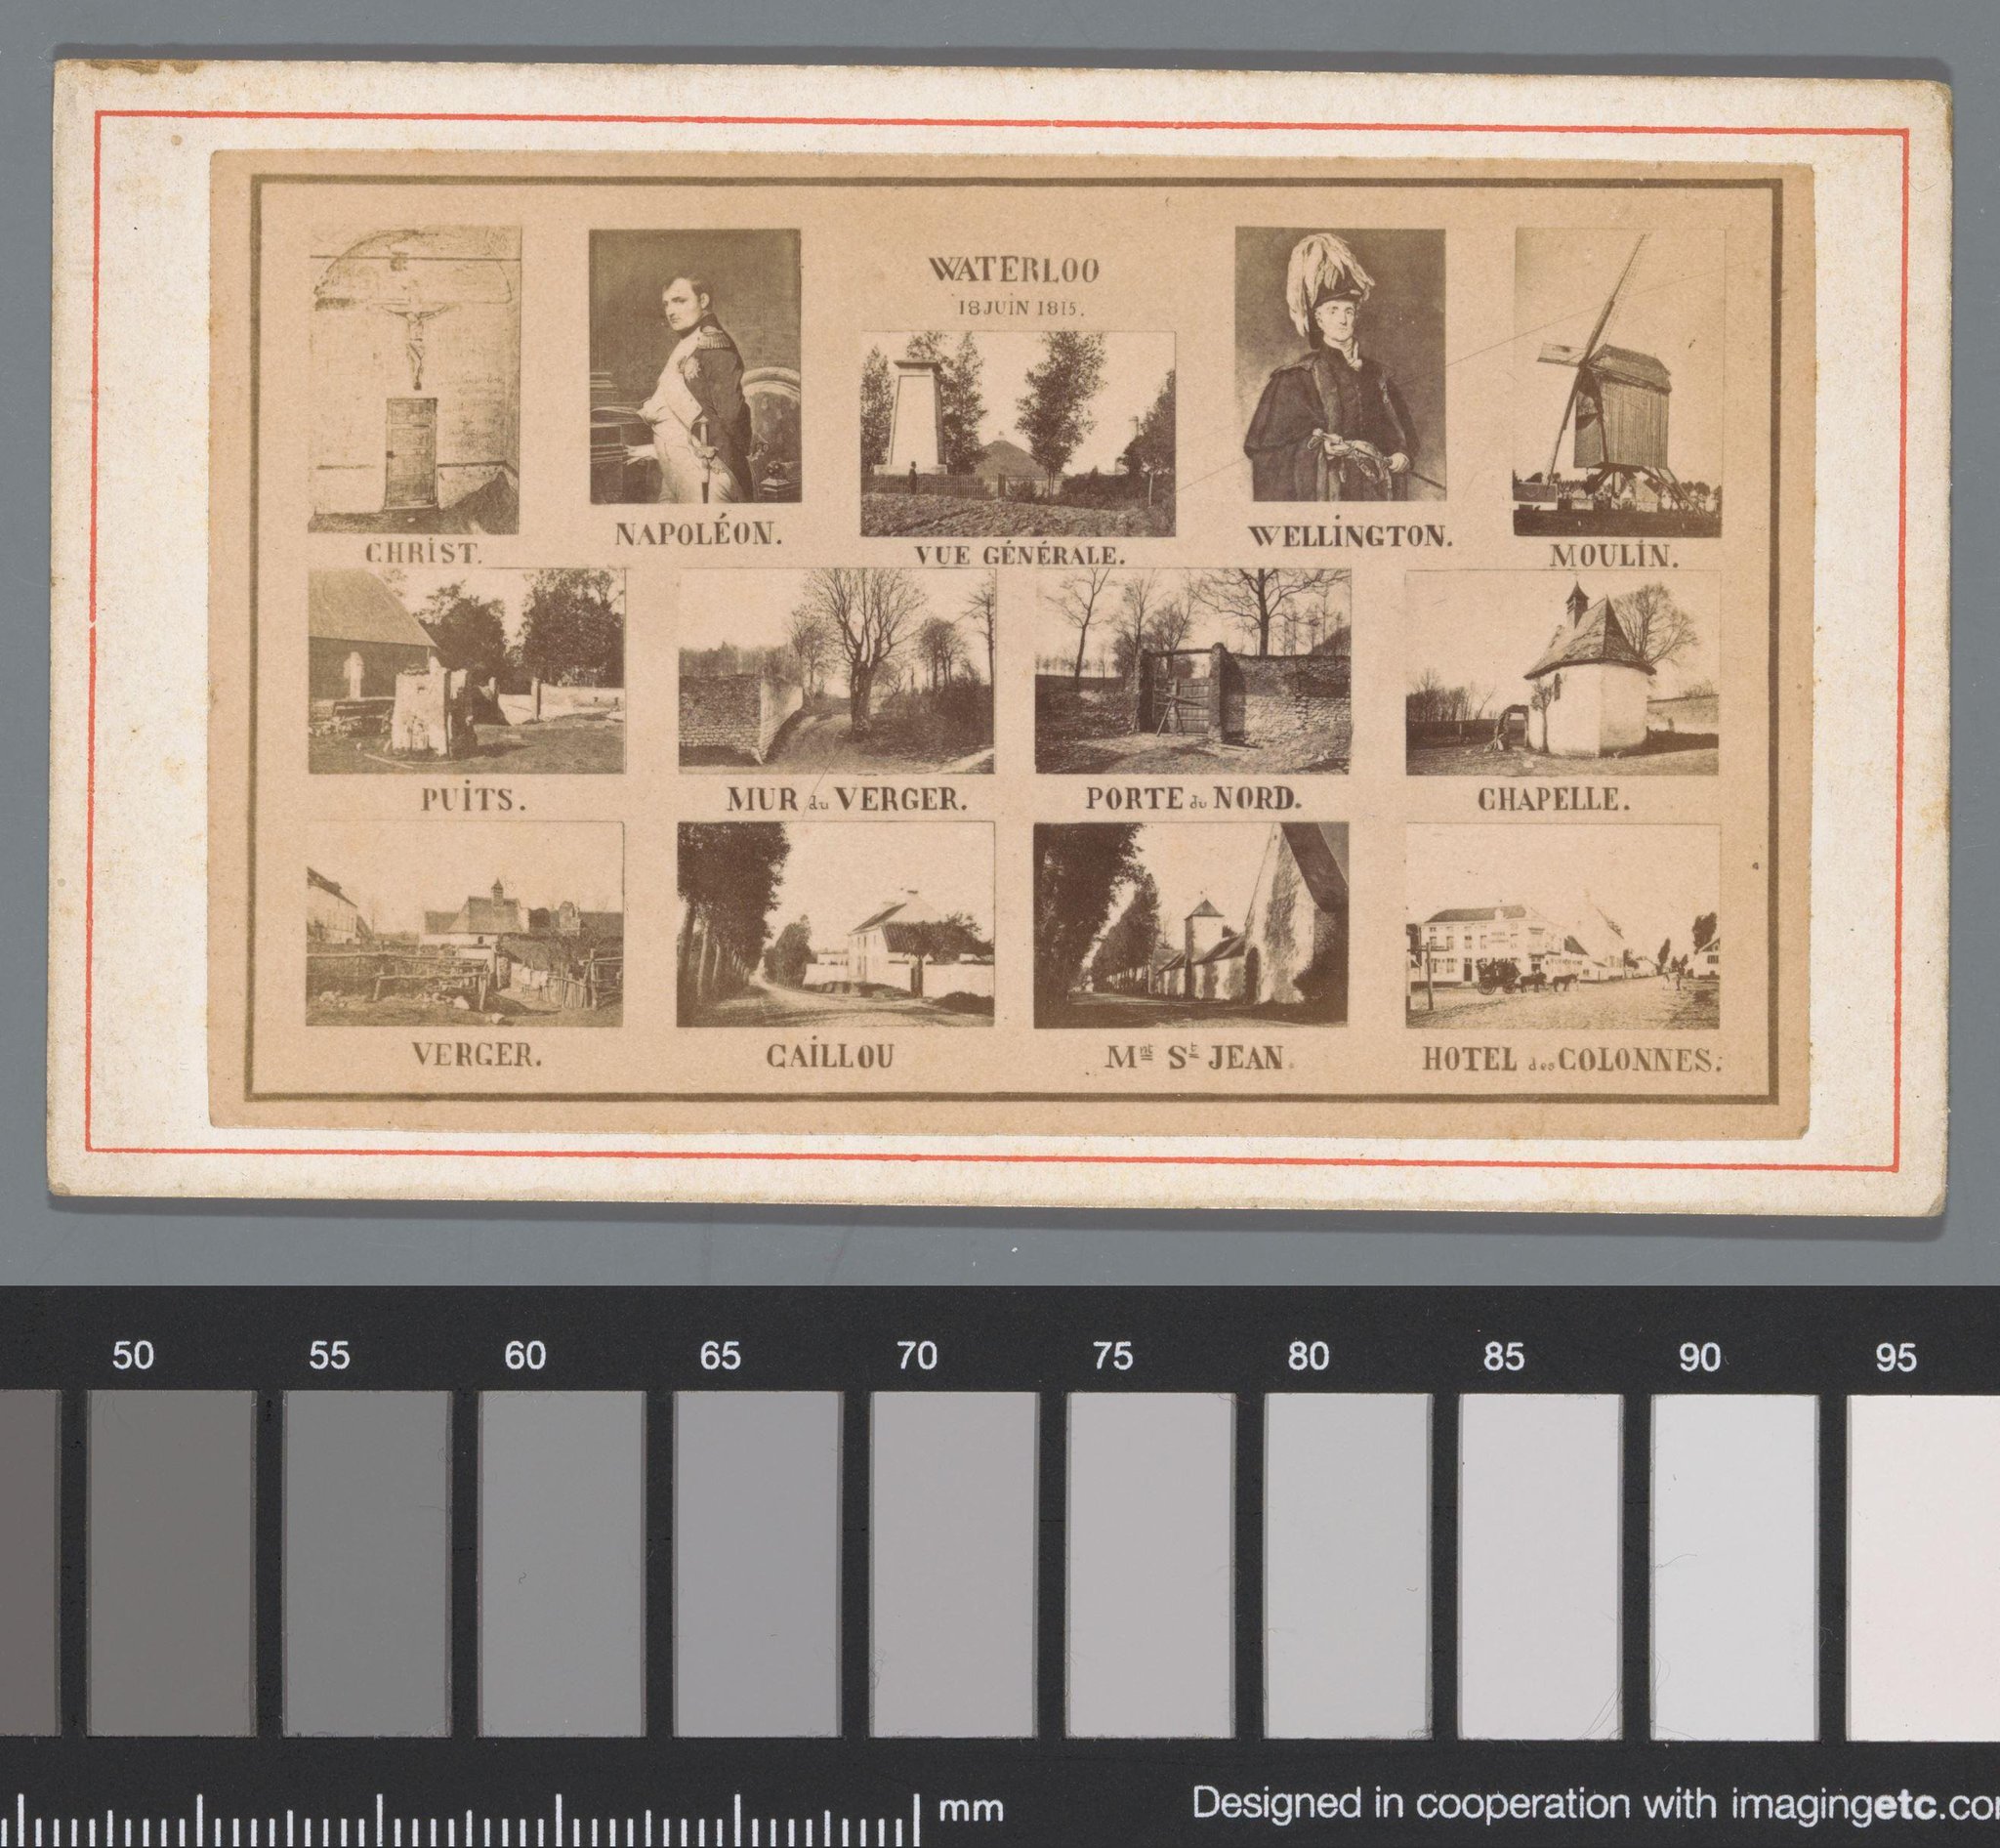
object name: carte de visite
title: Waterloo, 18 juin 1815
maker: Anonymous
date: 1855-1885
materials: cardboard, paper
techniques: albumen print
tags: poster